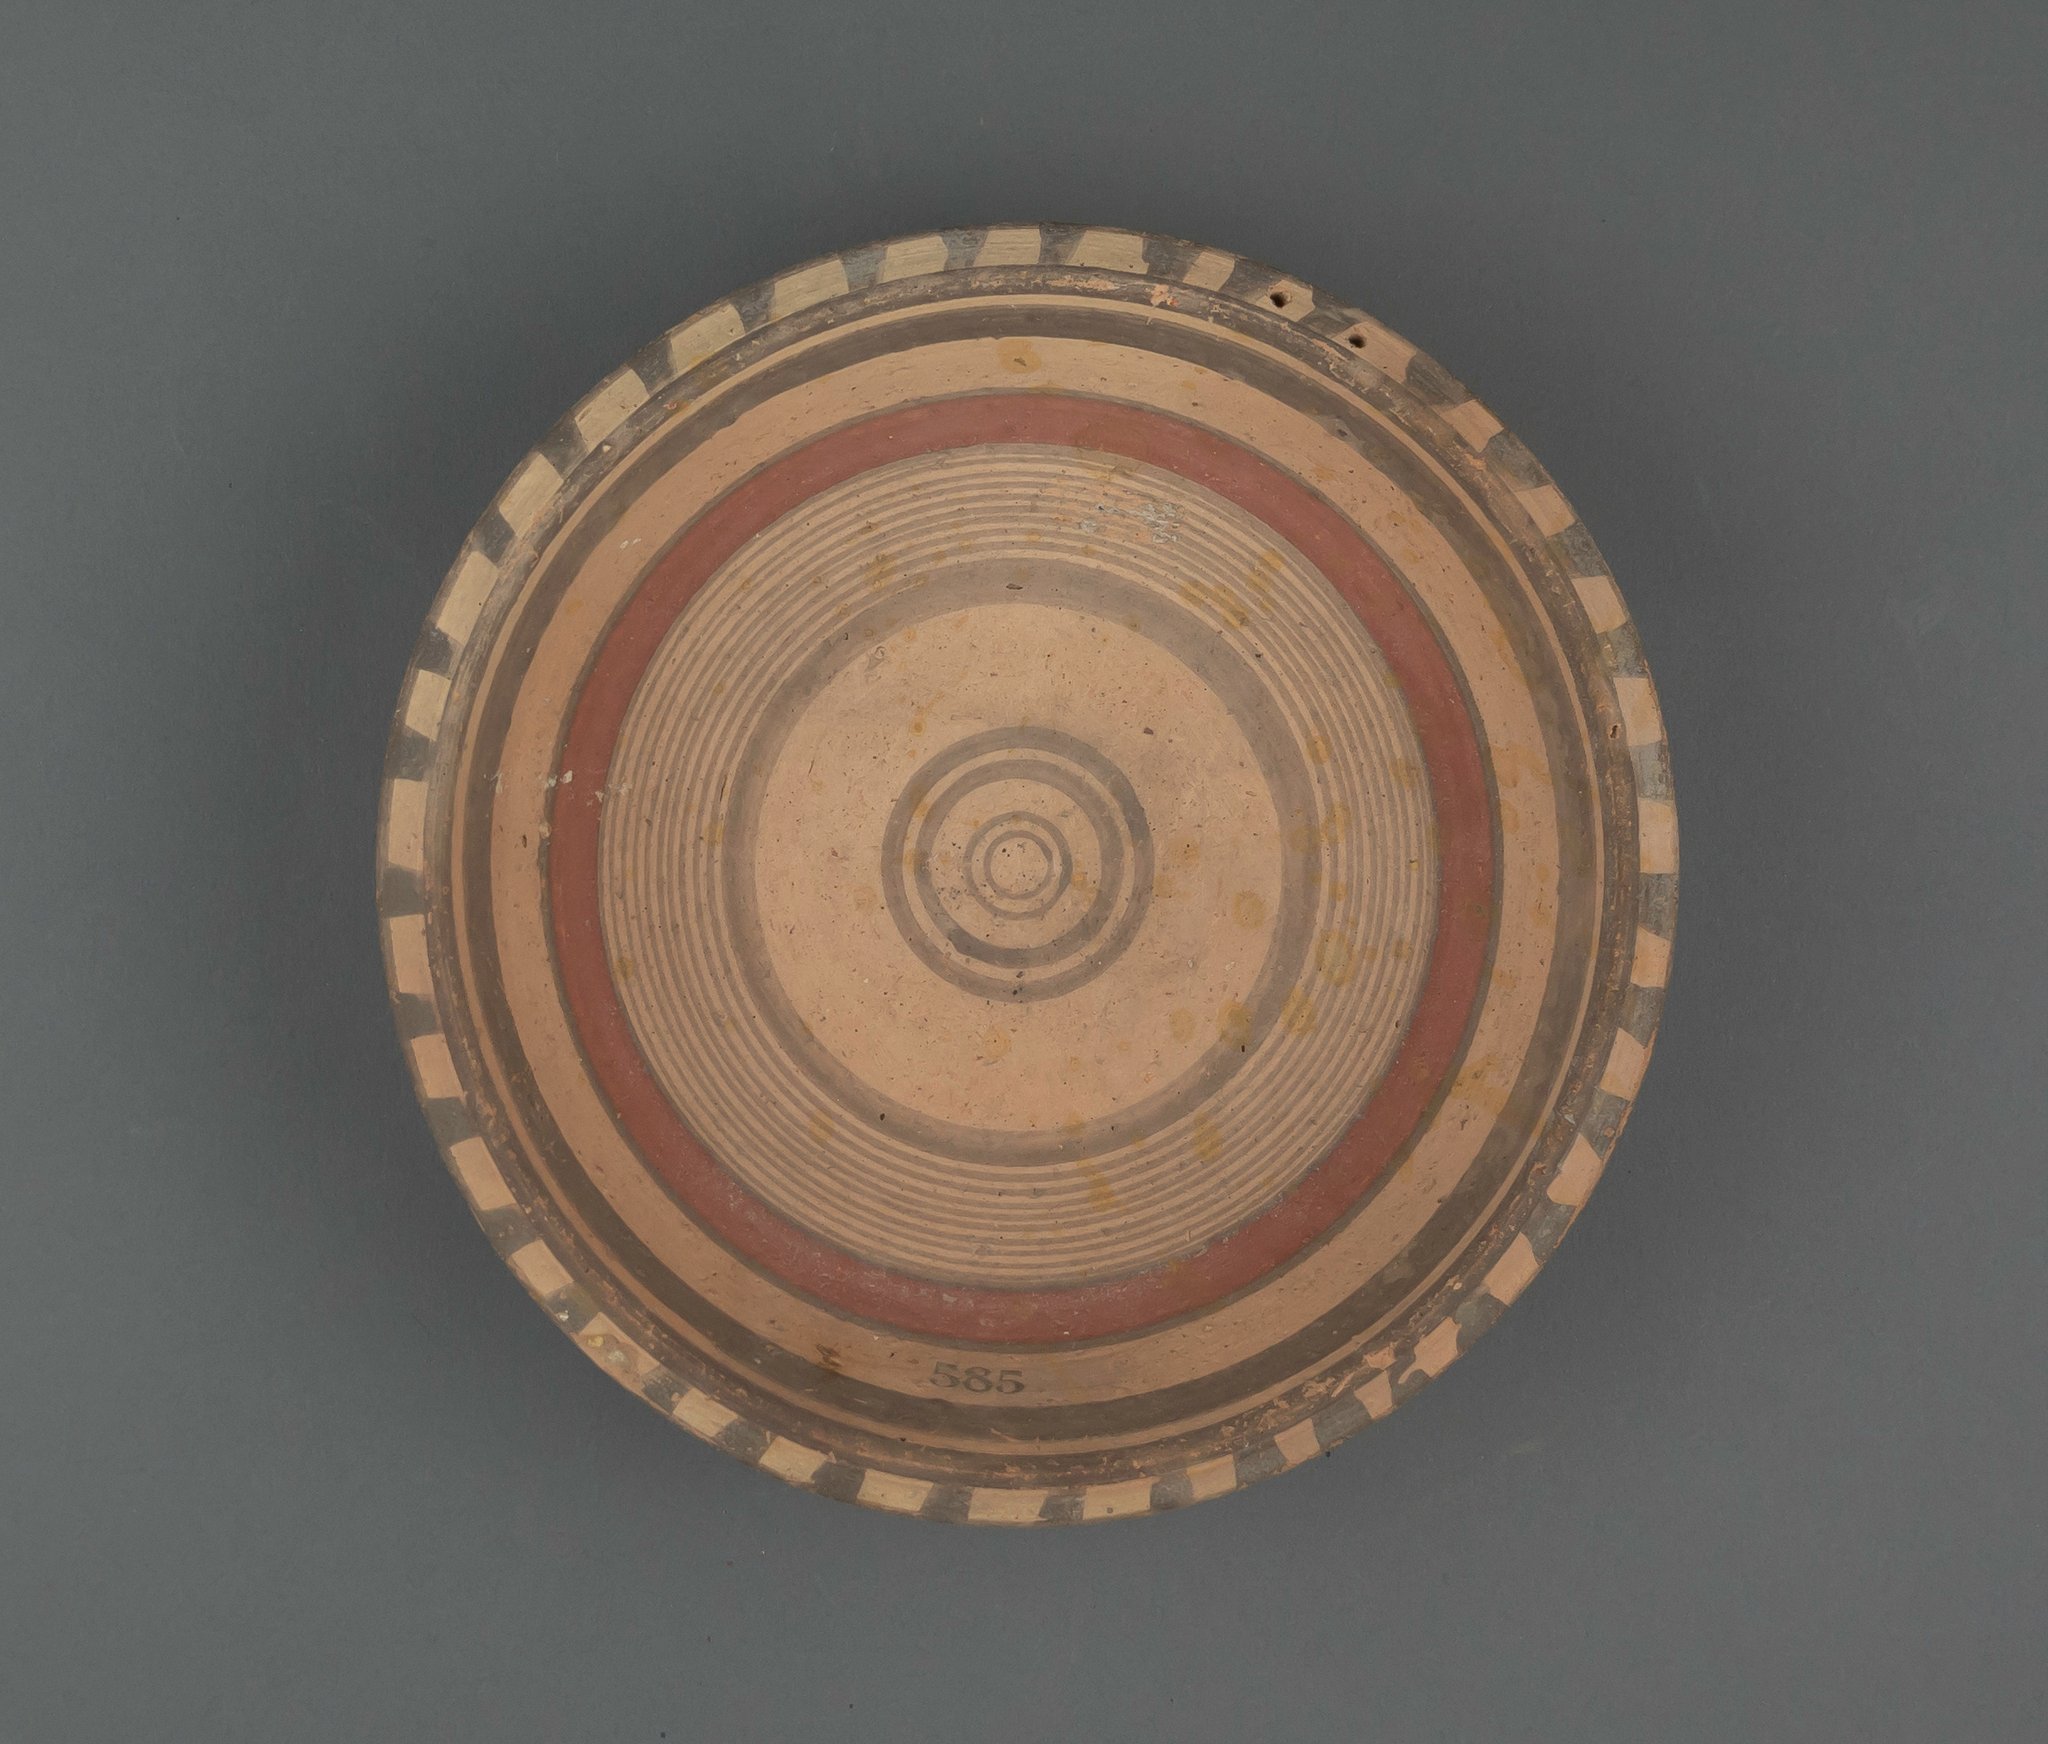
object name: bowl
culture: cypriot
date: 600-480 BCE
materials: terracotta